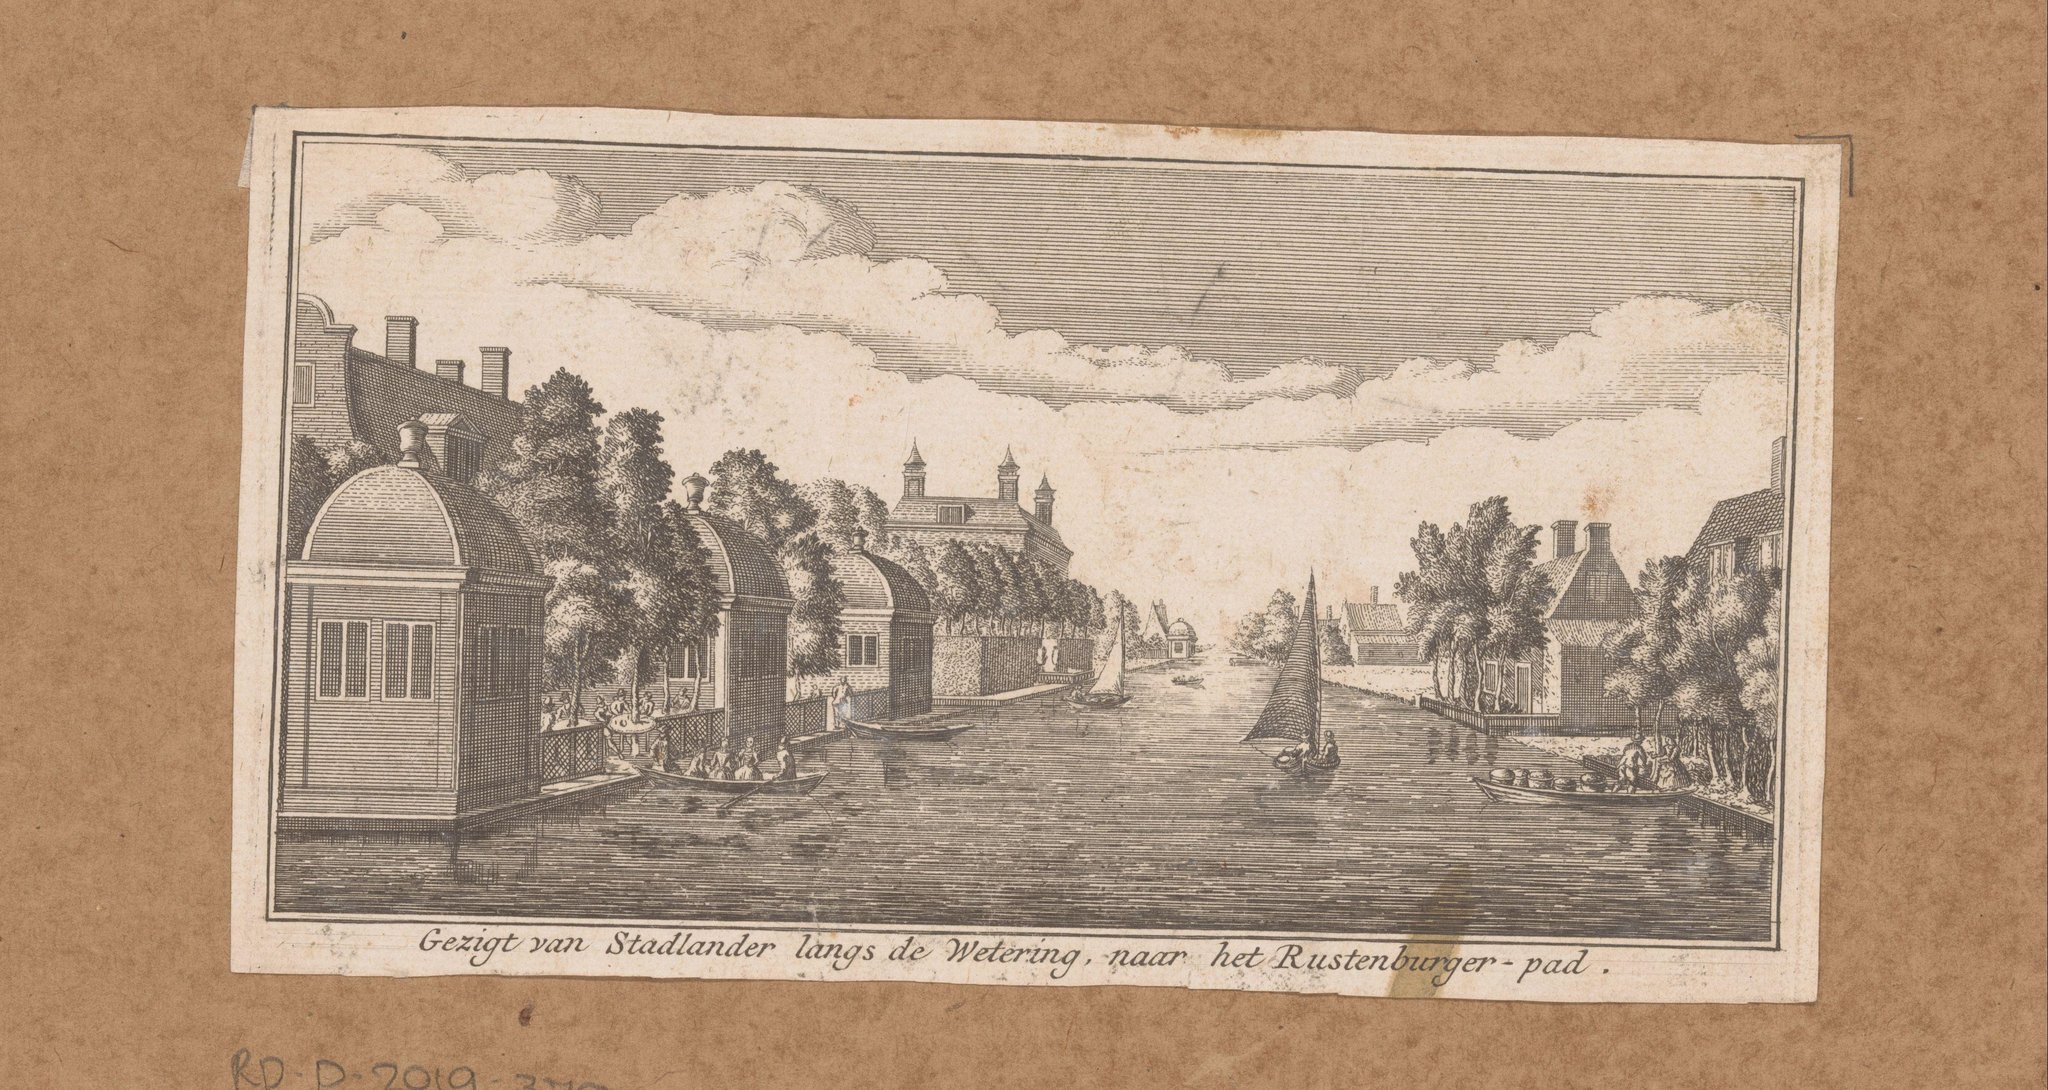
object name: print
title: Gezigt van Stadlander langs de Wetering, naar het Rustenburger-pad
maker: gerardus condet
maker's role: print maker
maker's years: 1715-1764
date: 1725-1764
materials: paper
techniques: etching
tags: sailing-ship, sailing-boat, rowing-boat, canoe, etc., canals, waters (in city)